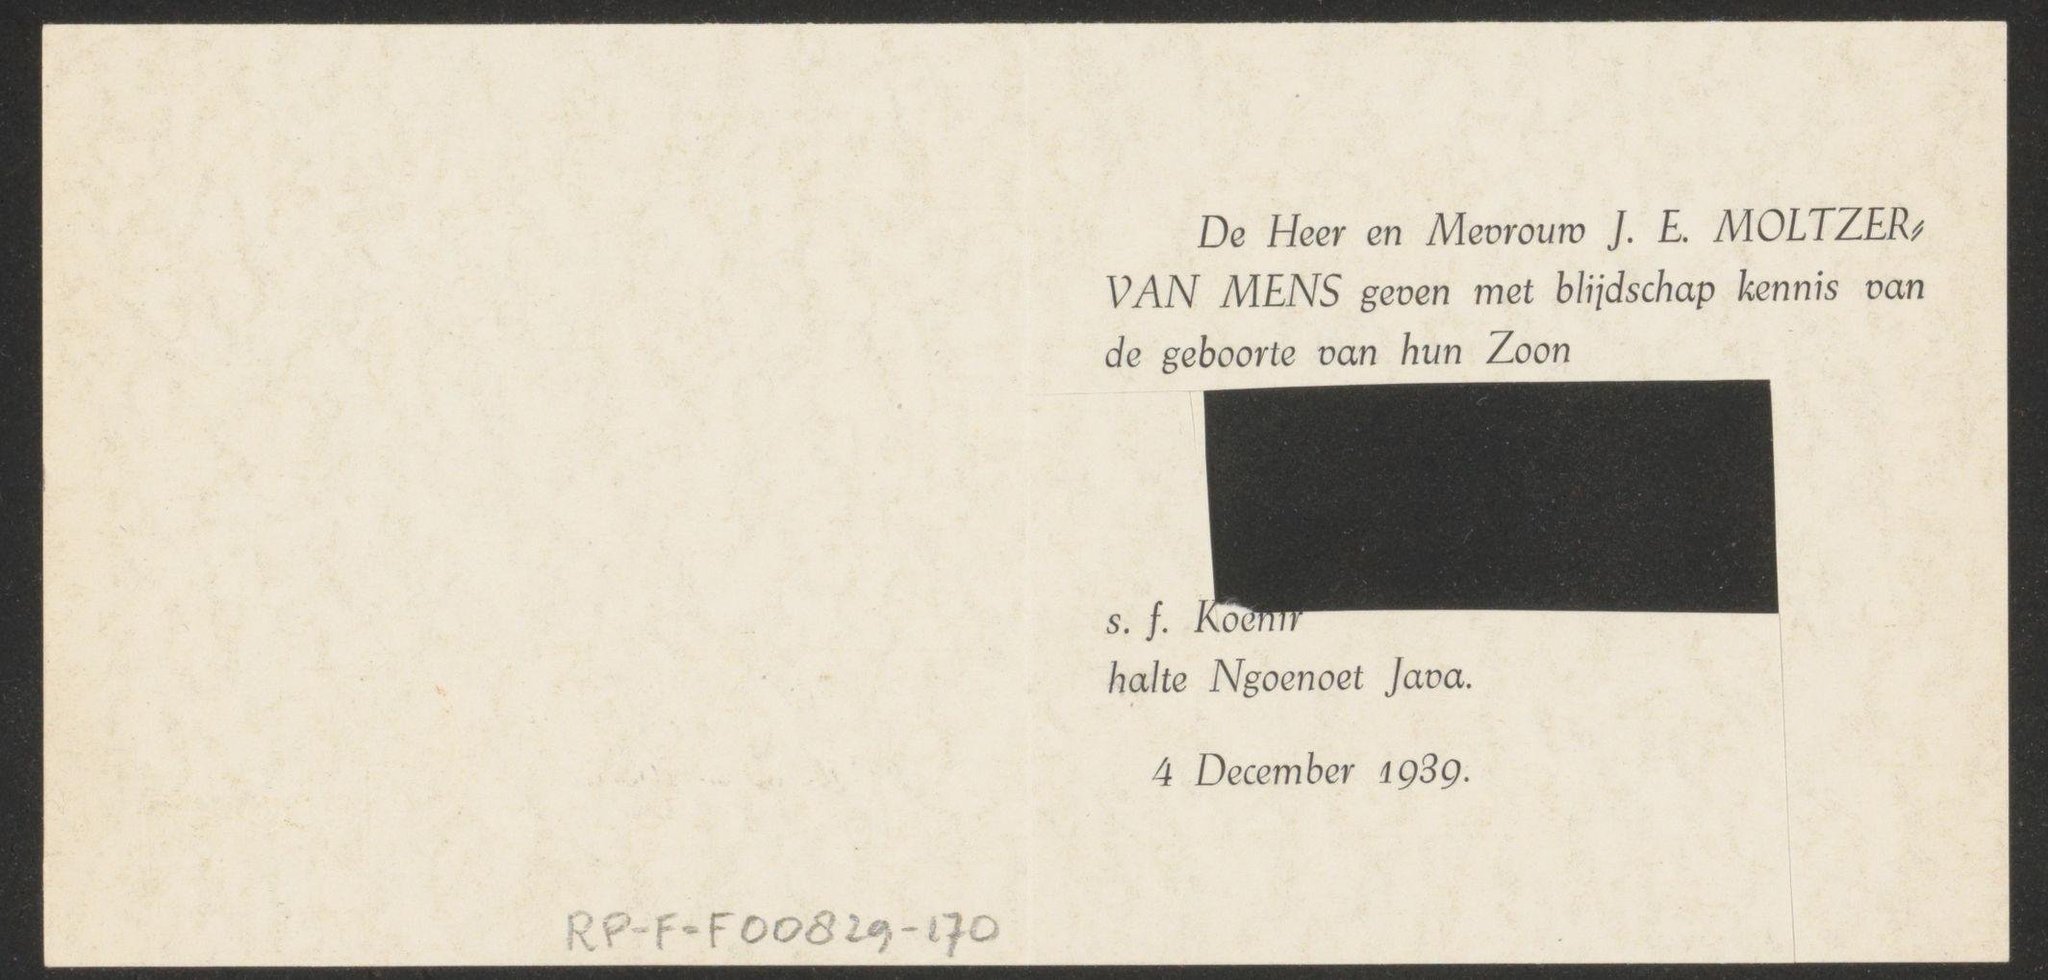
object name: birth announcement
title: Geboortekaart (deels uitgeknipt) van een jongen geboren op 4 december 1939 te Java, zoon van de heer en mevrouw J.E. Moltzer-Van Mens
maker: Anonymous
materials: paper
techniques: printing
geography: java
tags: further education (+ pupil), further education, confinement, birth, java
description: Onderdeel van Stamboek van de leerlingen der Koloniale School voor Meisjes en Vrouwen te 's-Gravenhage deel II (1930-1949).